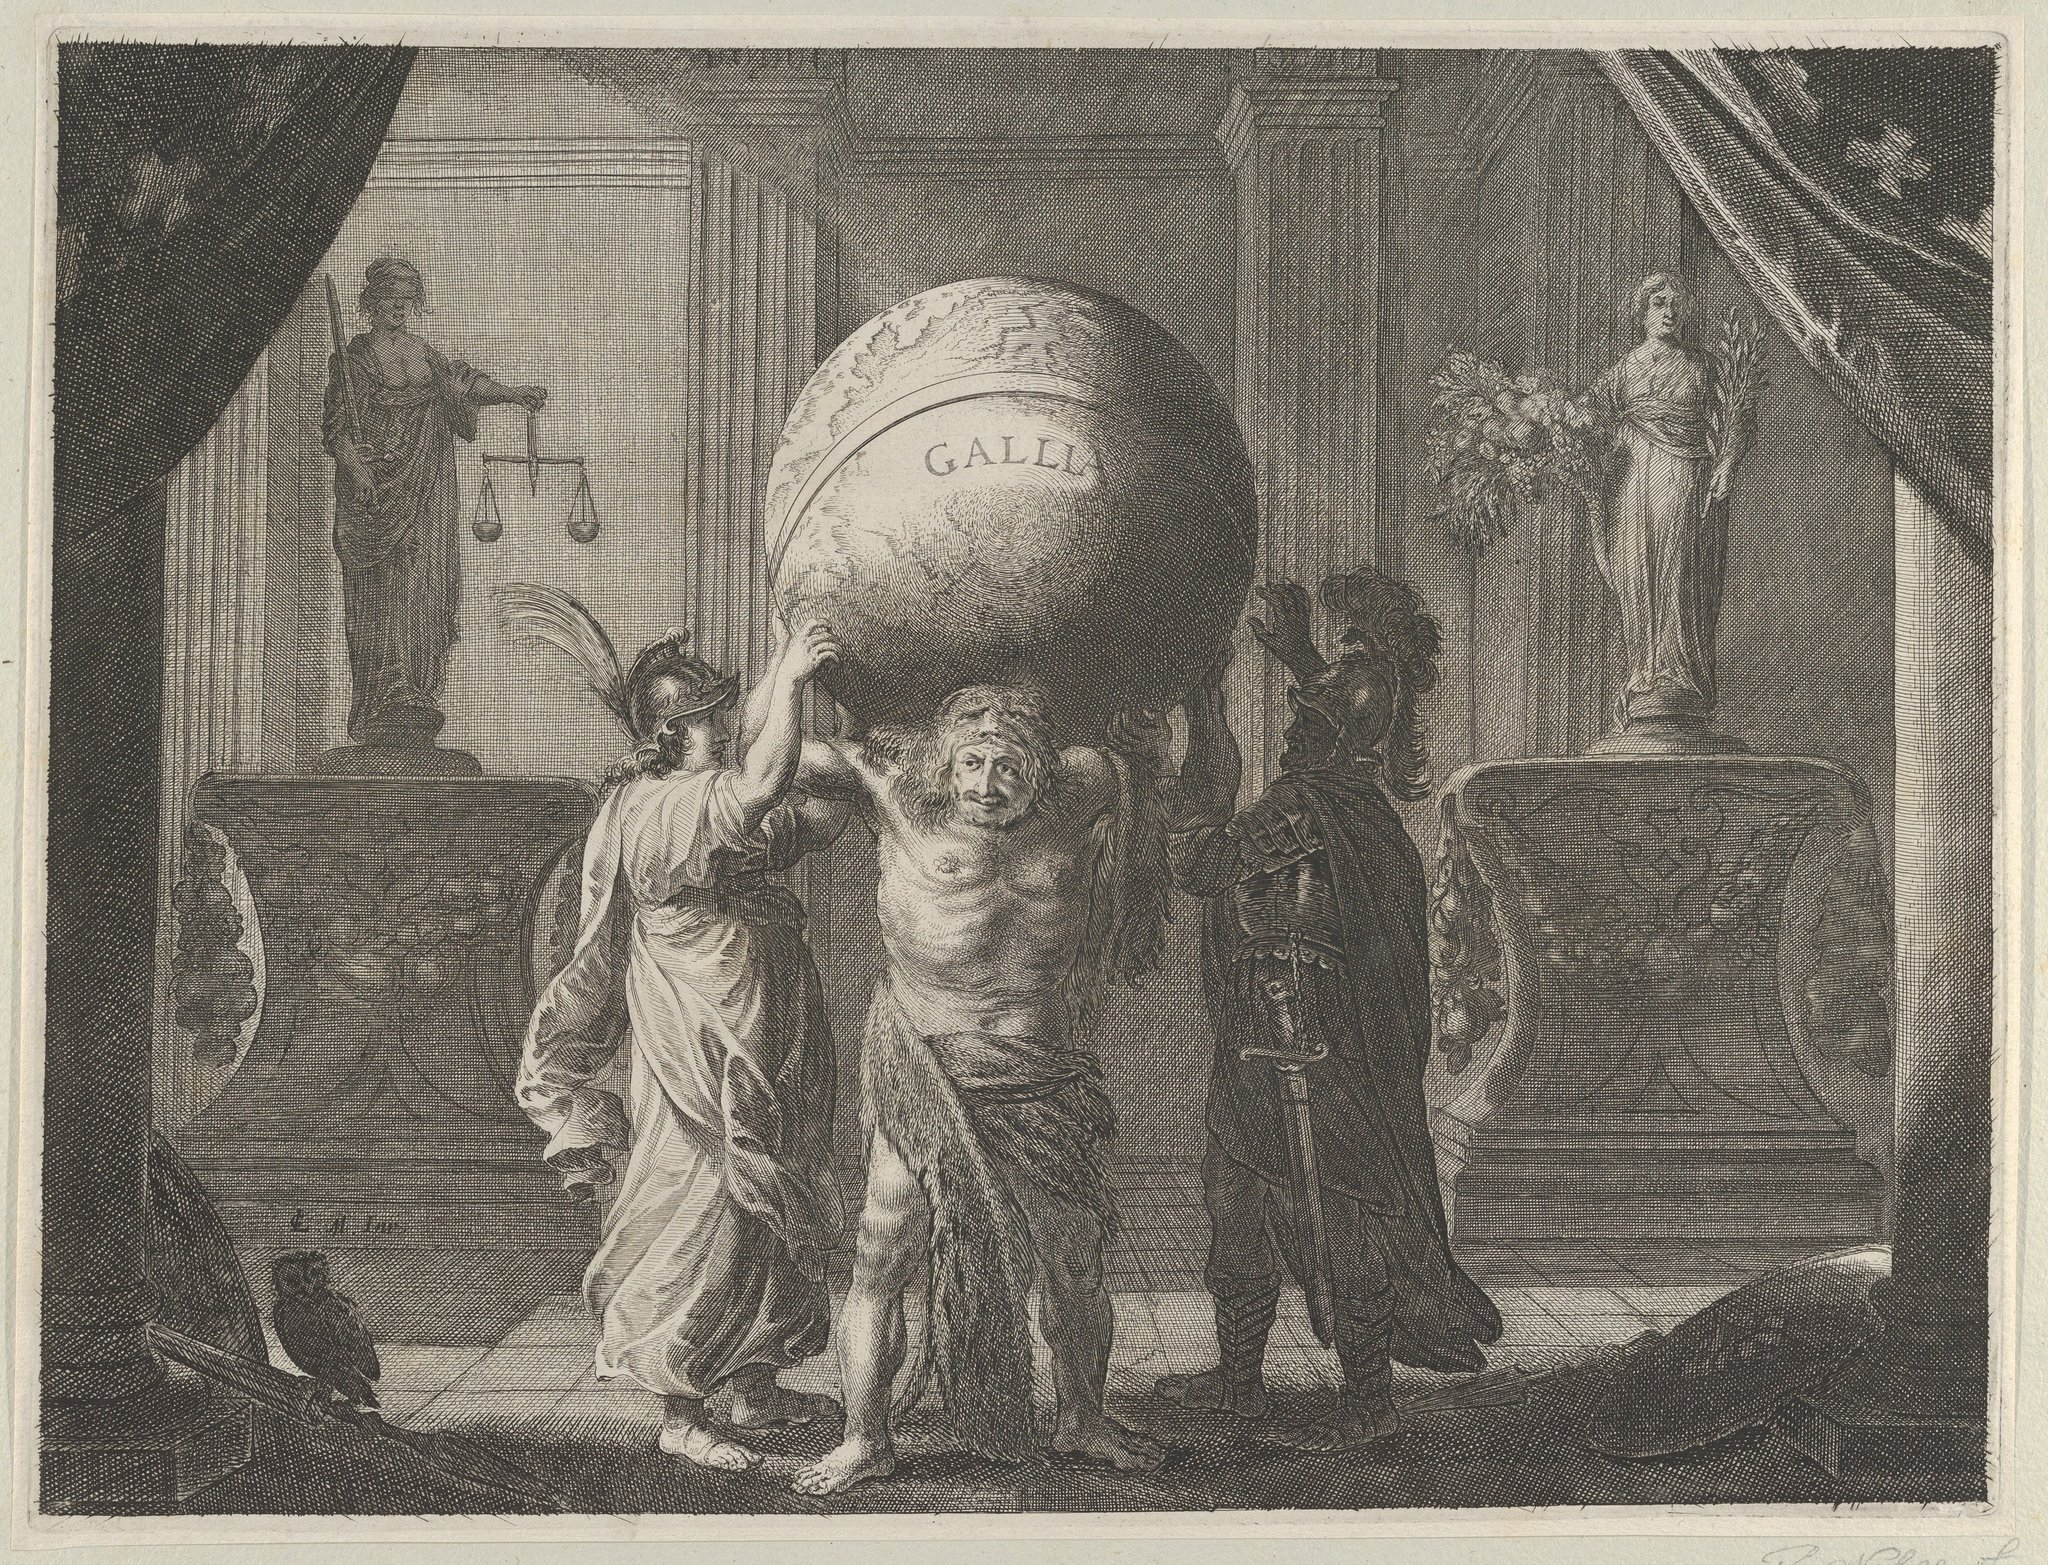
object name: print, fete, ornament architecture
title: Plate 13: Allegory on the Discord in France, from Caspar Barlaeus, "Medicea Hospes"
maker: pieter nolpe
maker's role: artist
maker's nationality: dutch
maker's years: 1613-1614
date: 1638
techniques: etching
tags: men